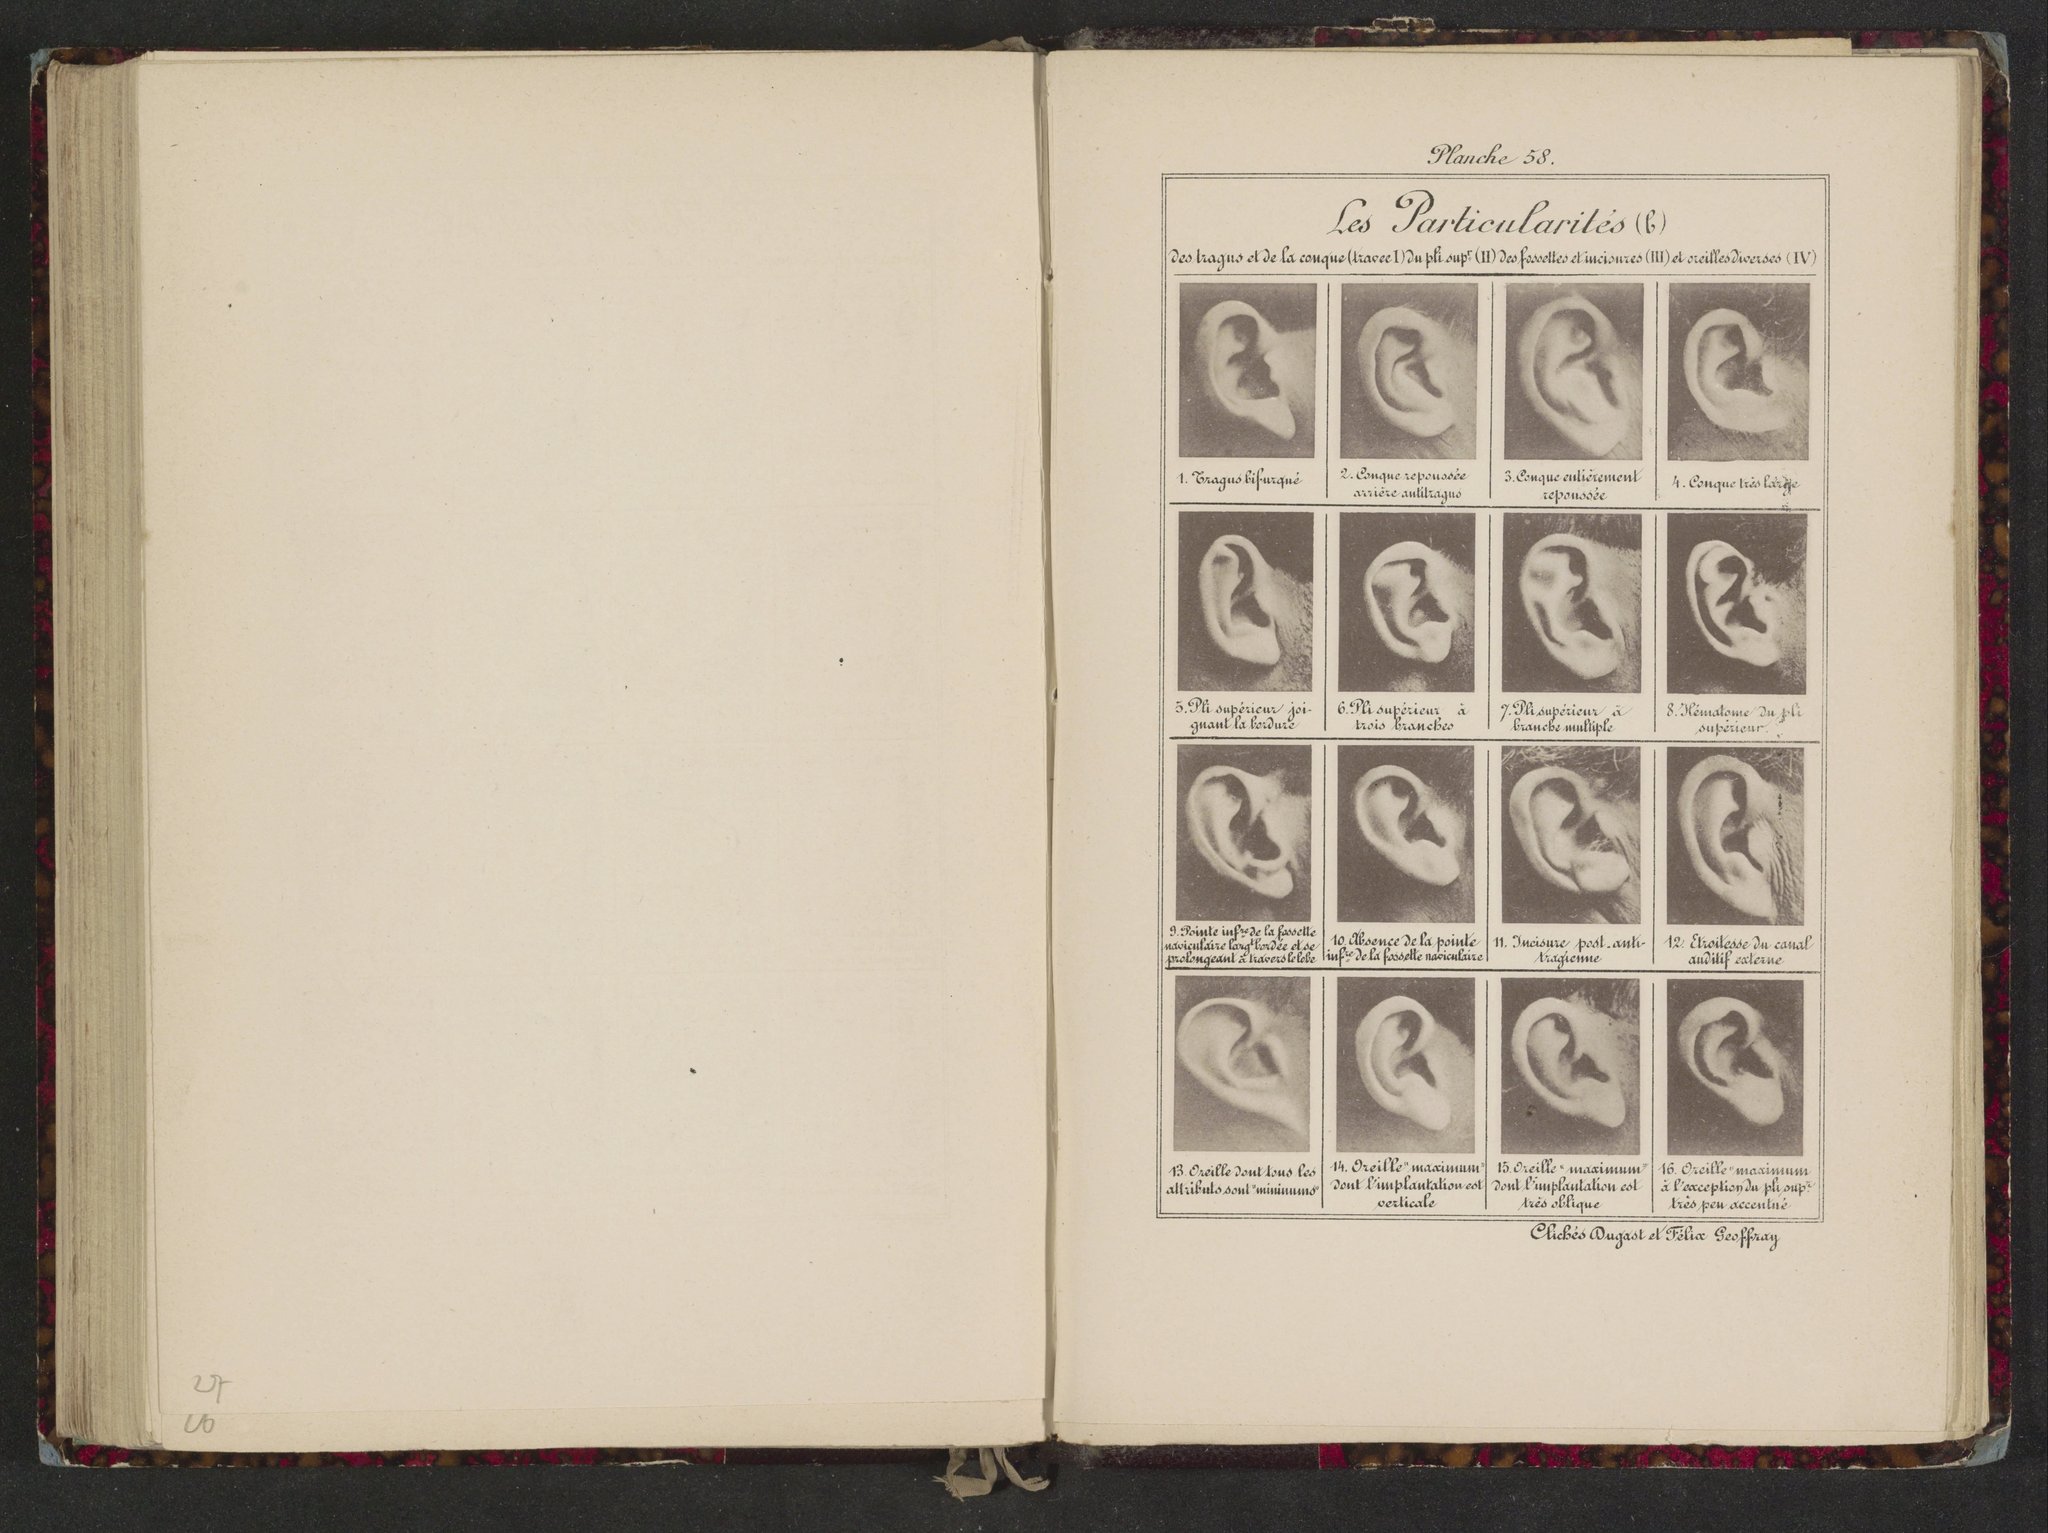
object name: photomechanical print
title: Zestien afbeeldingen van oren, gerangschikt op vorm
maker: Anonymous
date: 1880-1893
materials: paper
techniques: photograph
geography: france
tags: ears, france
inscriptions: number: ‘1. (...) 16.’, inscription: ‘(...) Oreille ''maximum'' à l'exception du pli supr. très peu accentué.’, number: ‘Planche 58.’